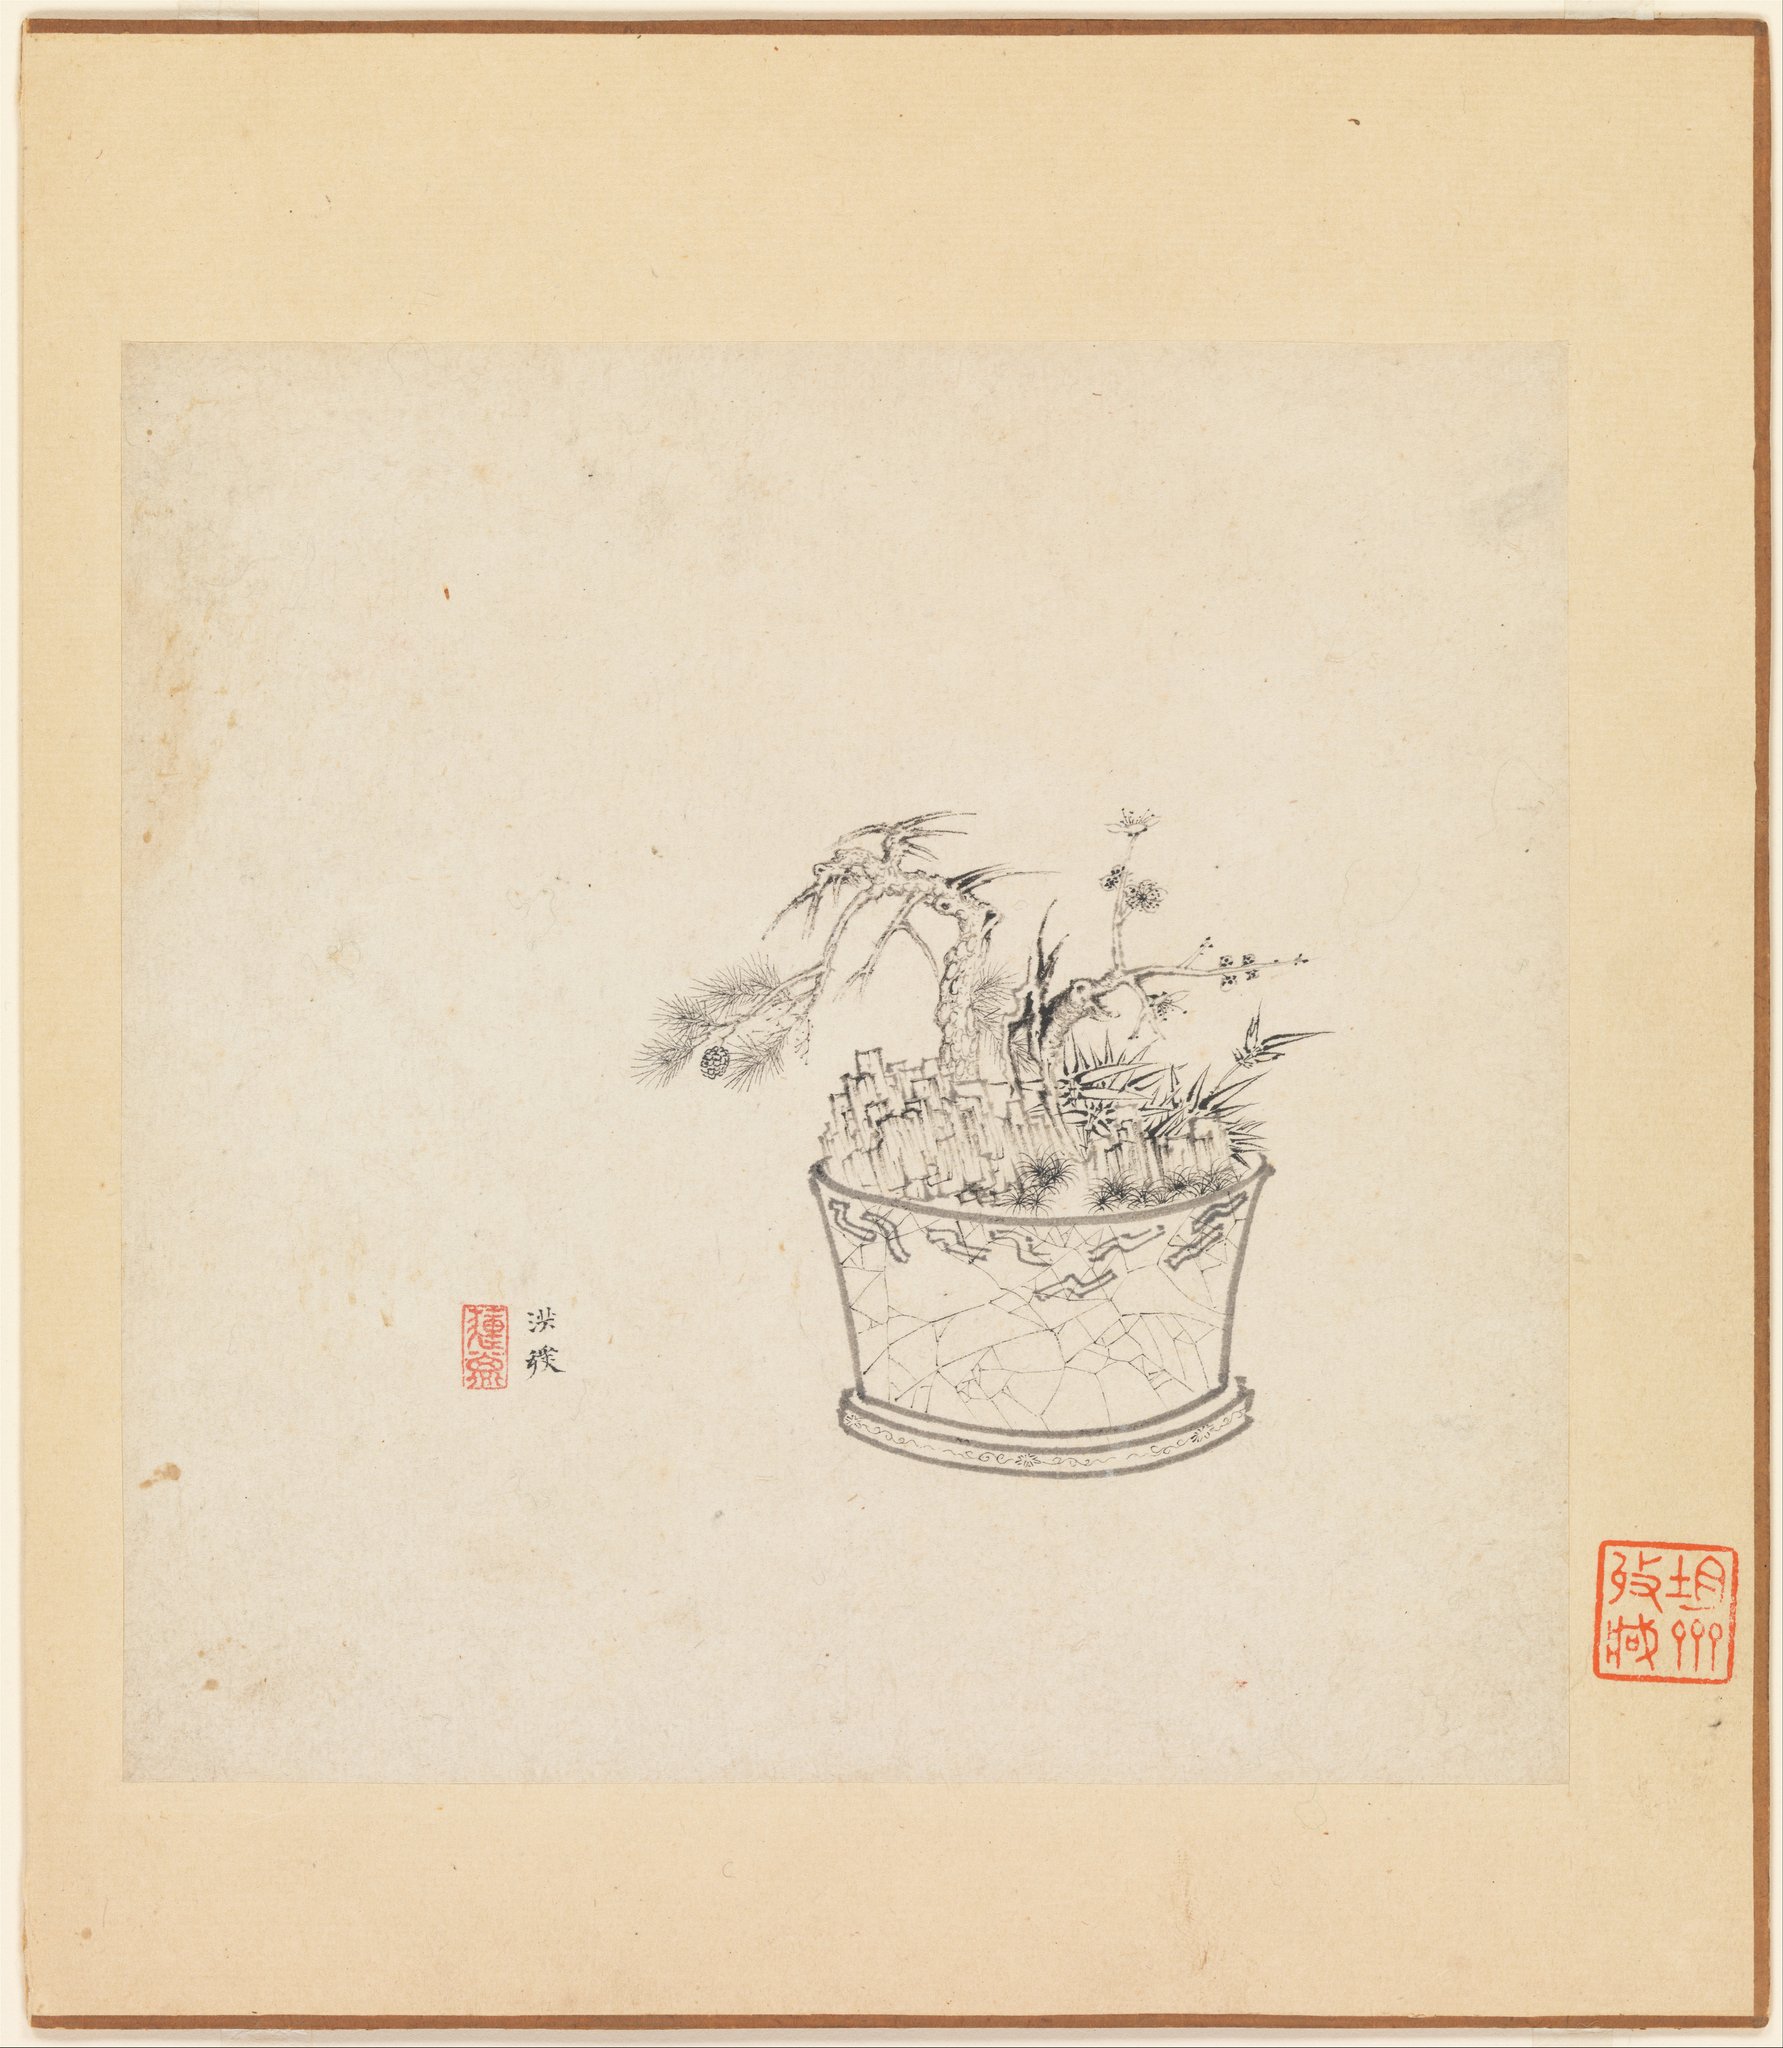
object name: album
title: Miscellaneous Studies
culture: chinese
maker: chen hongshou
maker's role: artist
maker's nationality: chinese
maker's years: 1598-1652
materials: ink, paper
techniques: painting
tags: plants